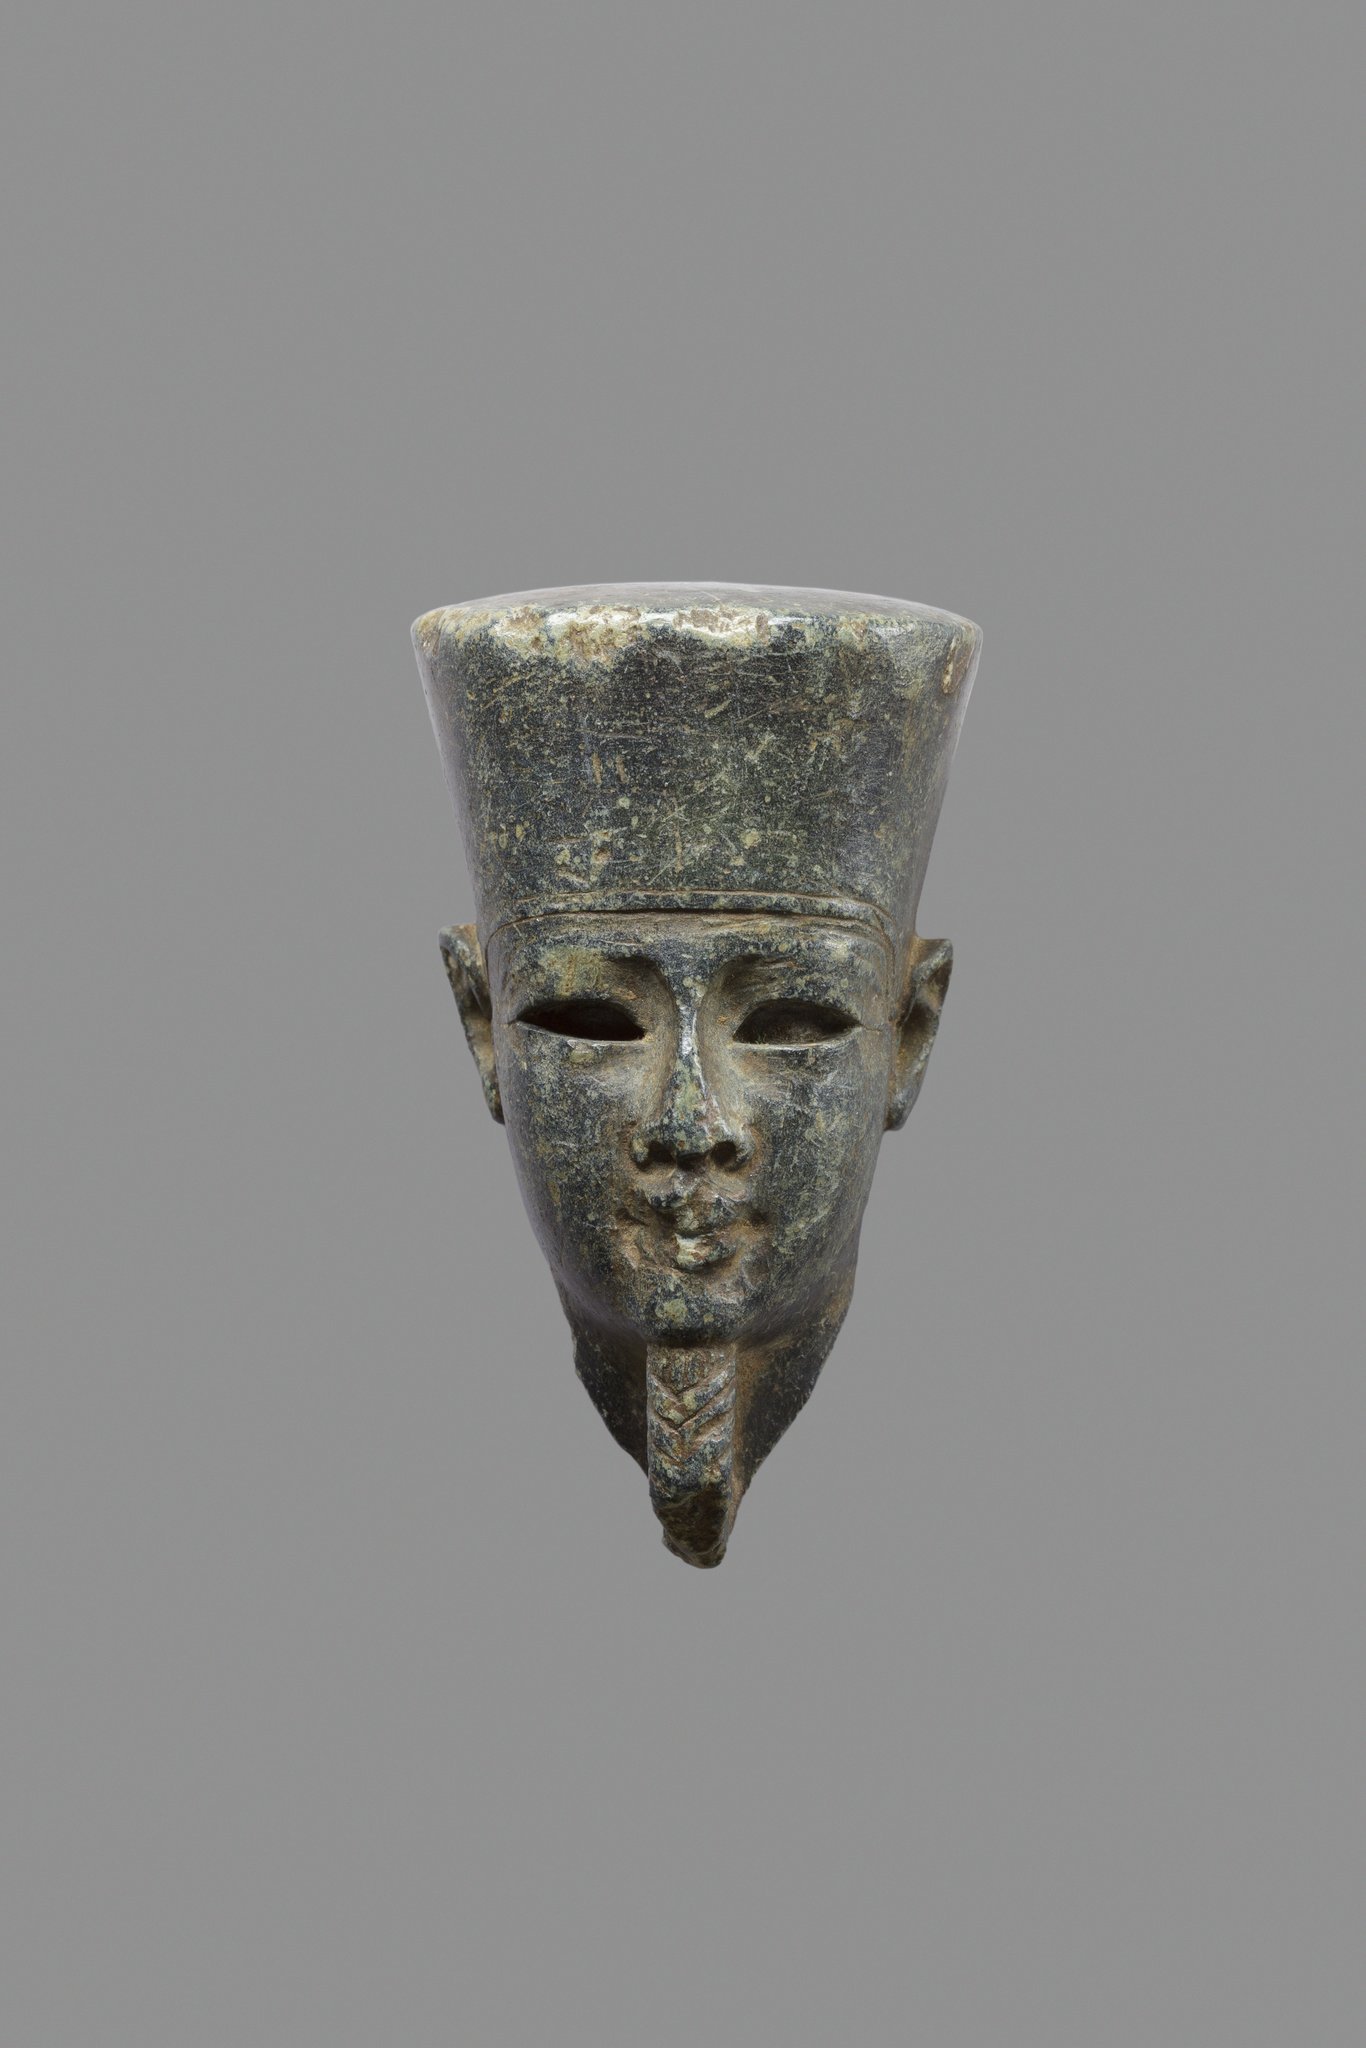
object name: head of a figure of amun min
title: Head possibly from a figure of Amun-Min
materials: stone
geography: egypt